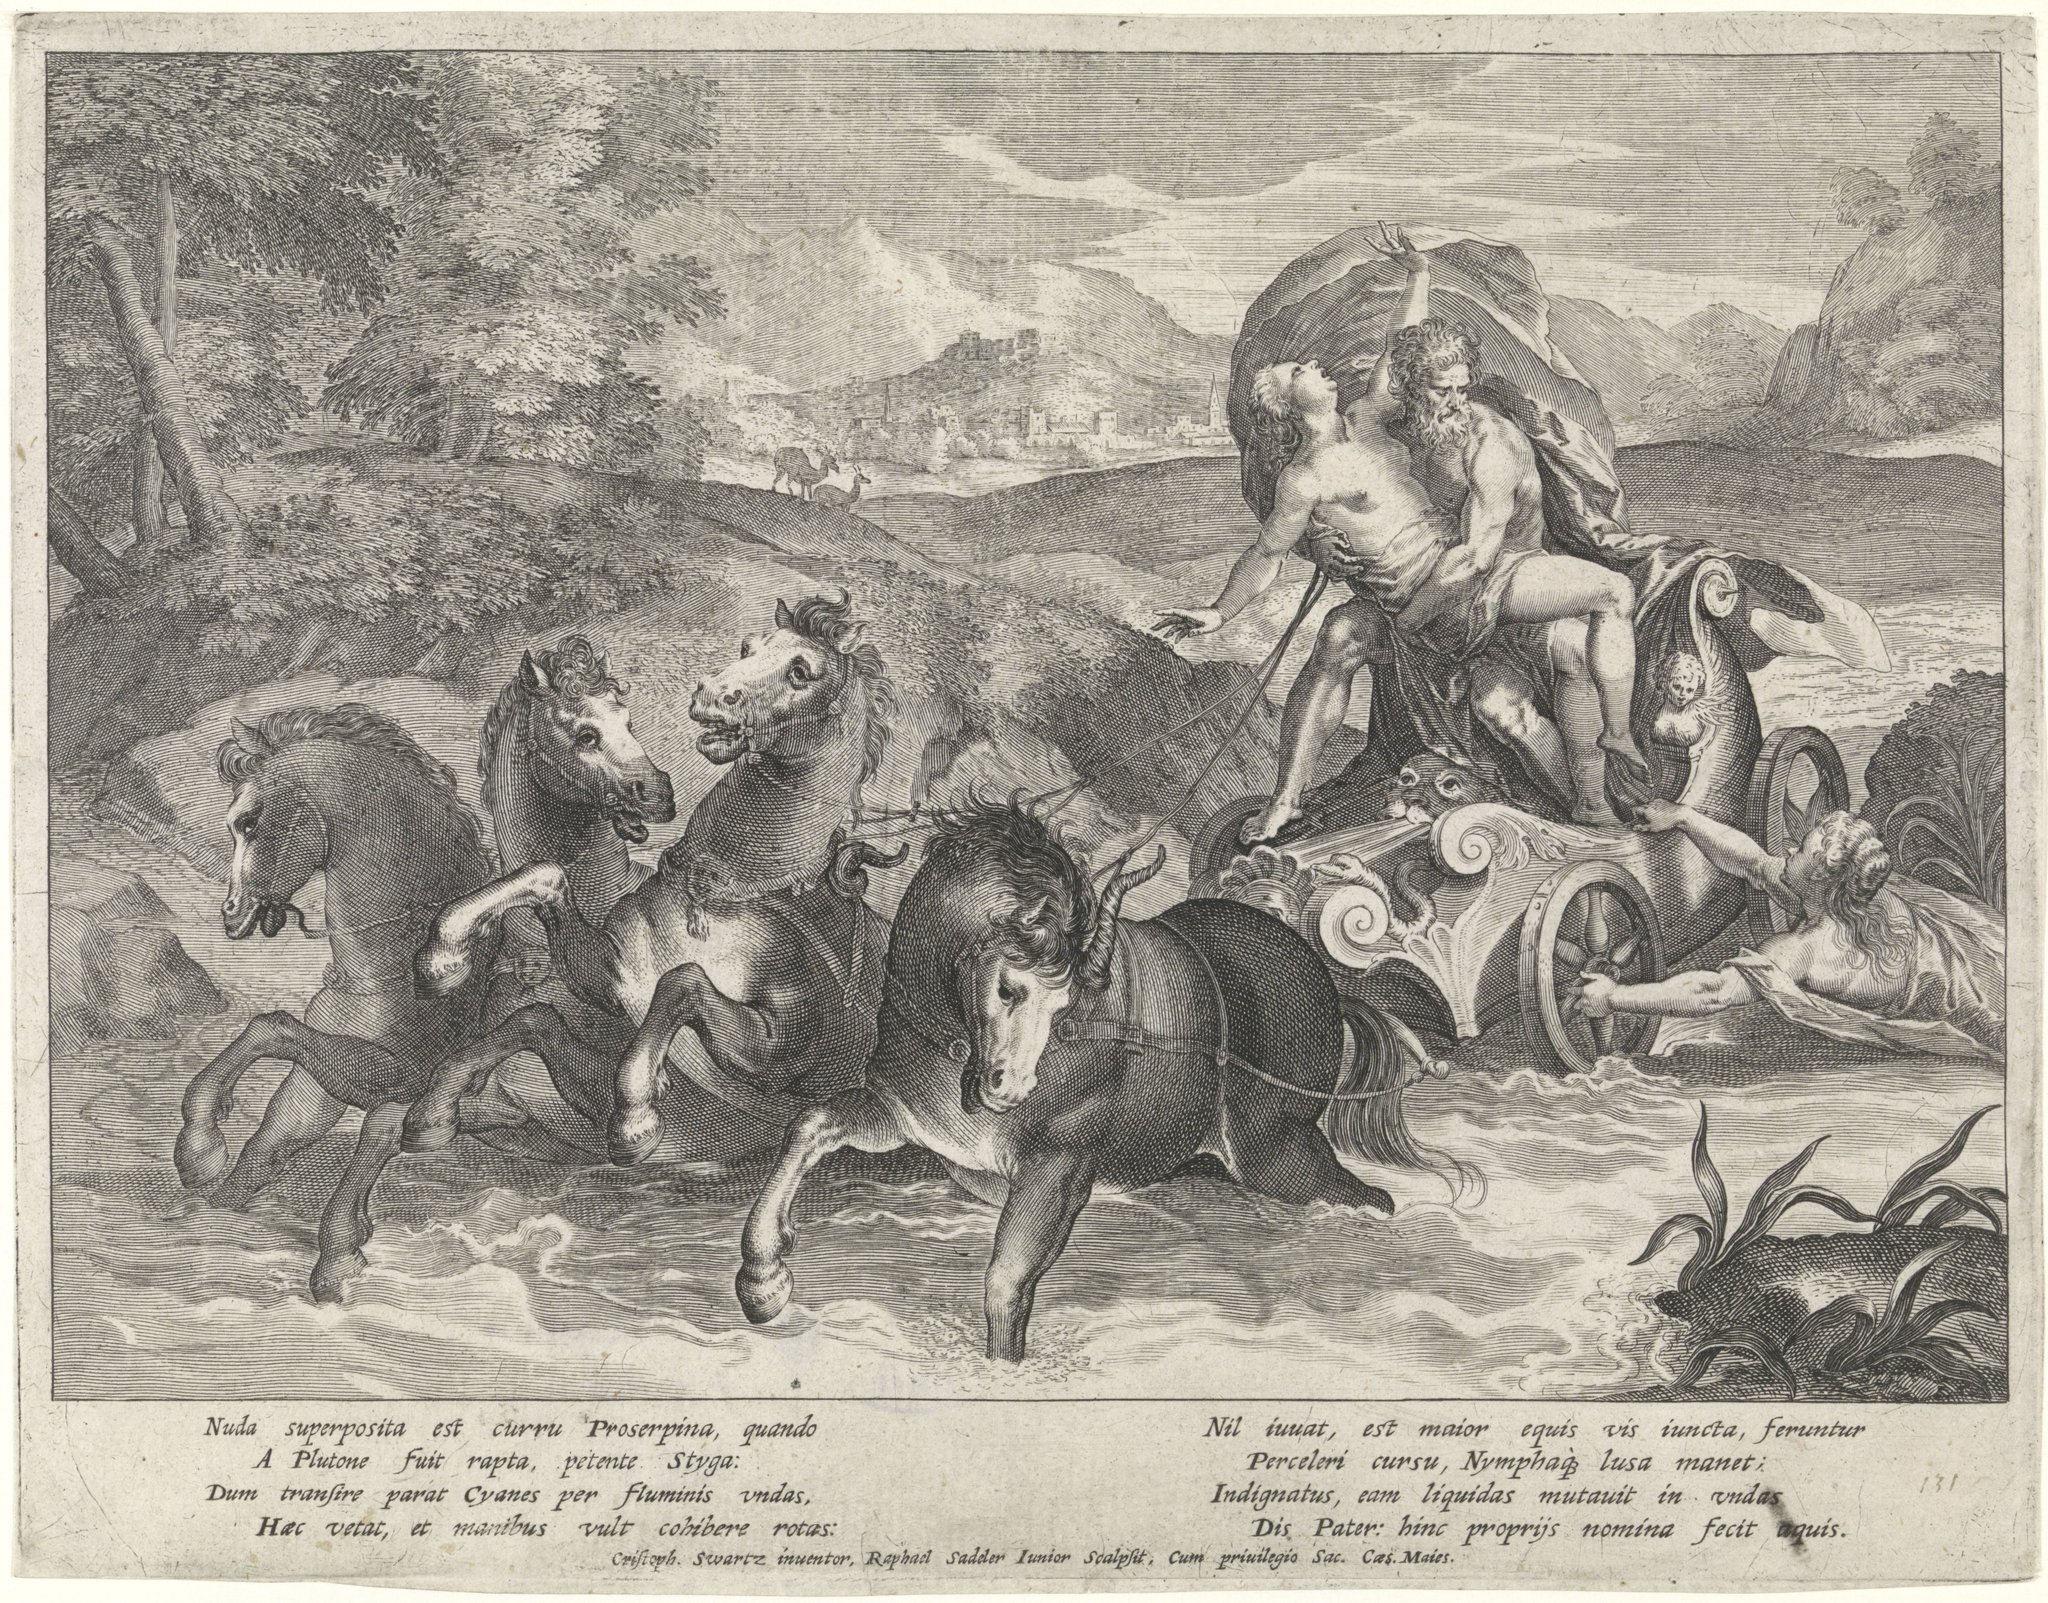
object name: print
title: Roof van Proserpina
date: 1594-1632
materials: paper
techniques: engraving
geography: munich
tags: the rape of proserpina (by pluto in his chariot); possibly with diana and minerva trying to rescue her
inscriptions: collector's mark: Lugt 2760, collector's mark: Lugt 2228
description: De zegewagen van Pluto, getrokken door vier paarden, rijdt door een rivier. Pluto heeft Proserpina in zijn armen, die zich verzet tegen haar ontvoering. Een tweede nimf houdt de wagen vast.